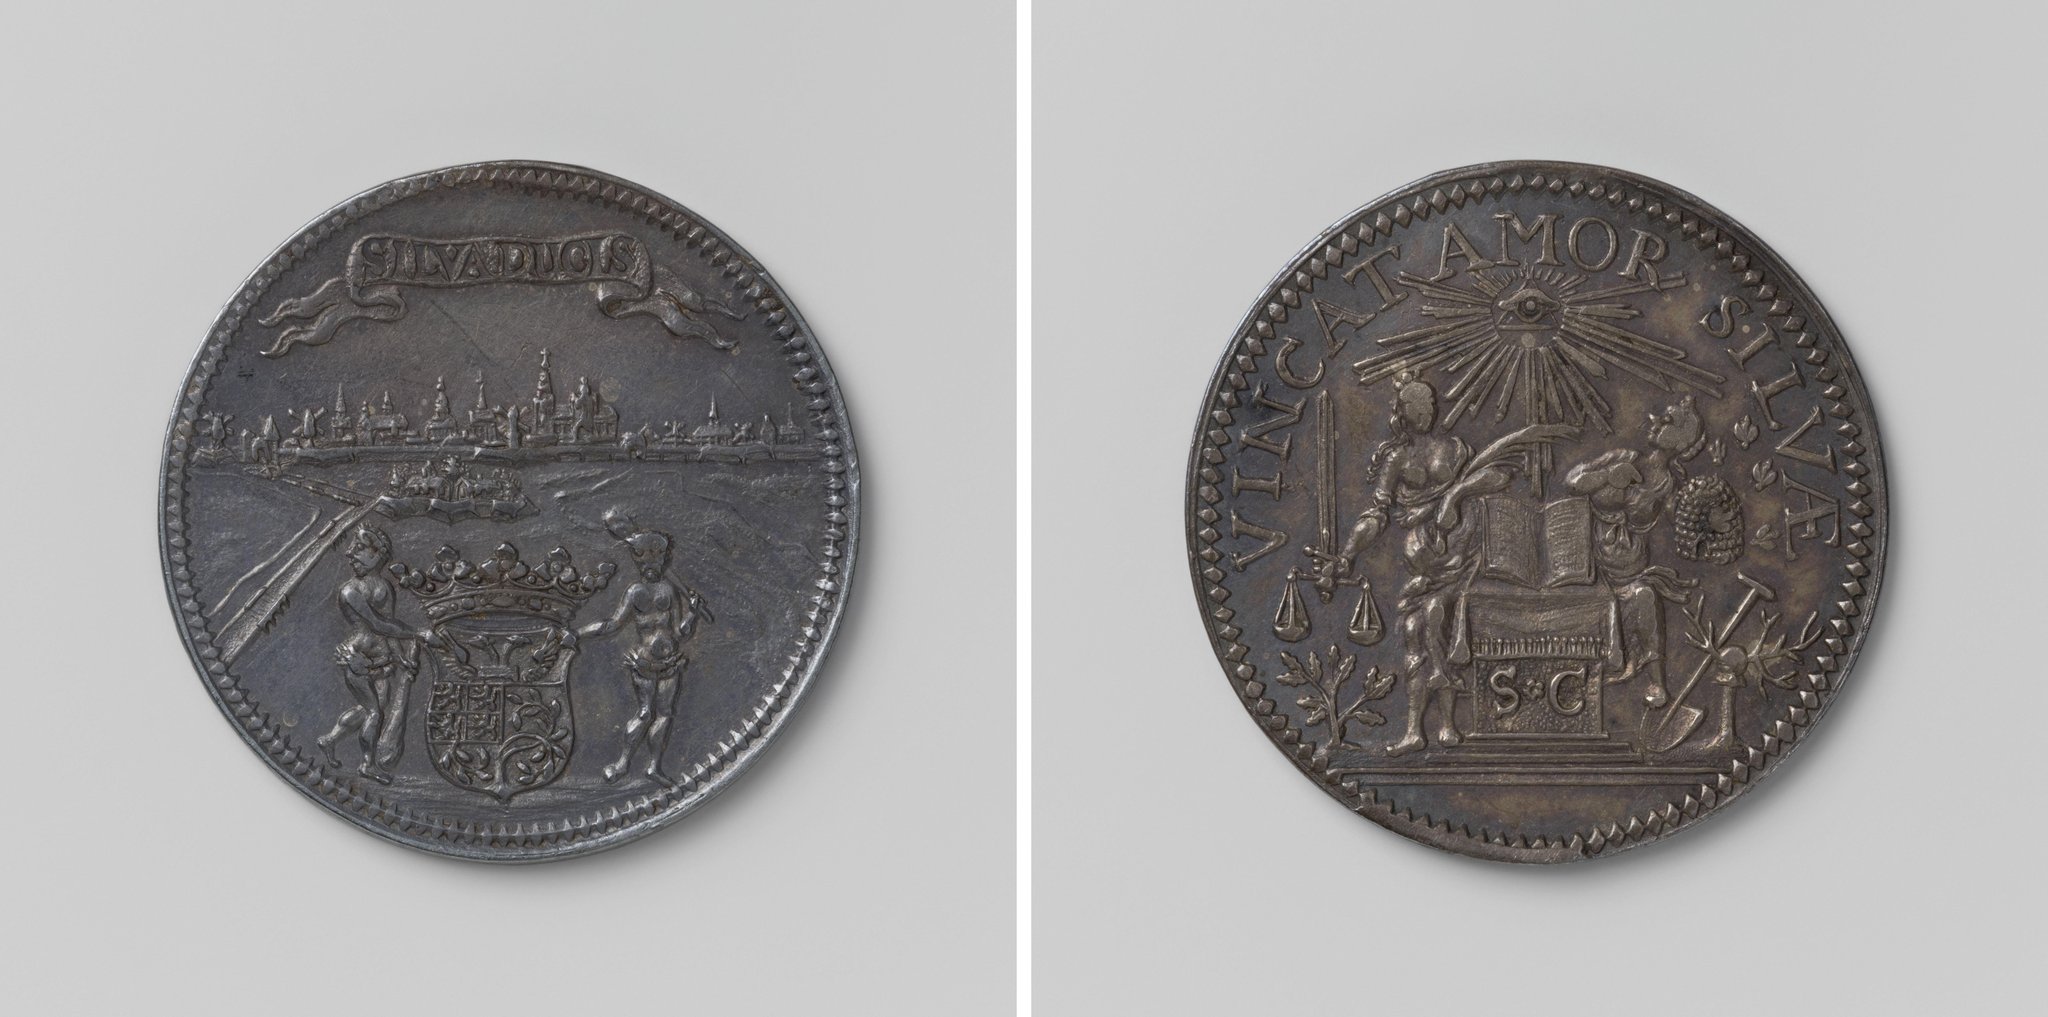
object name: council medal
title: Vroedschapspenning van de stad 's-Hertogenbosch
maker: theodorus casparus van berckel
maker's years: 1680-1734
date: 1707-1710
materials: silver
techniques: striking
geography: den bosch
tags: den bosch